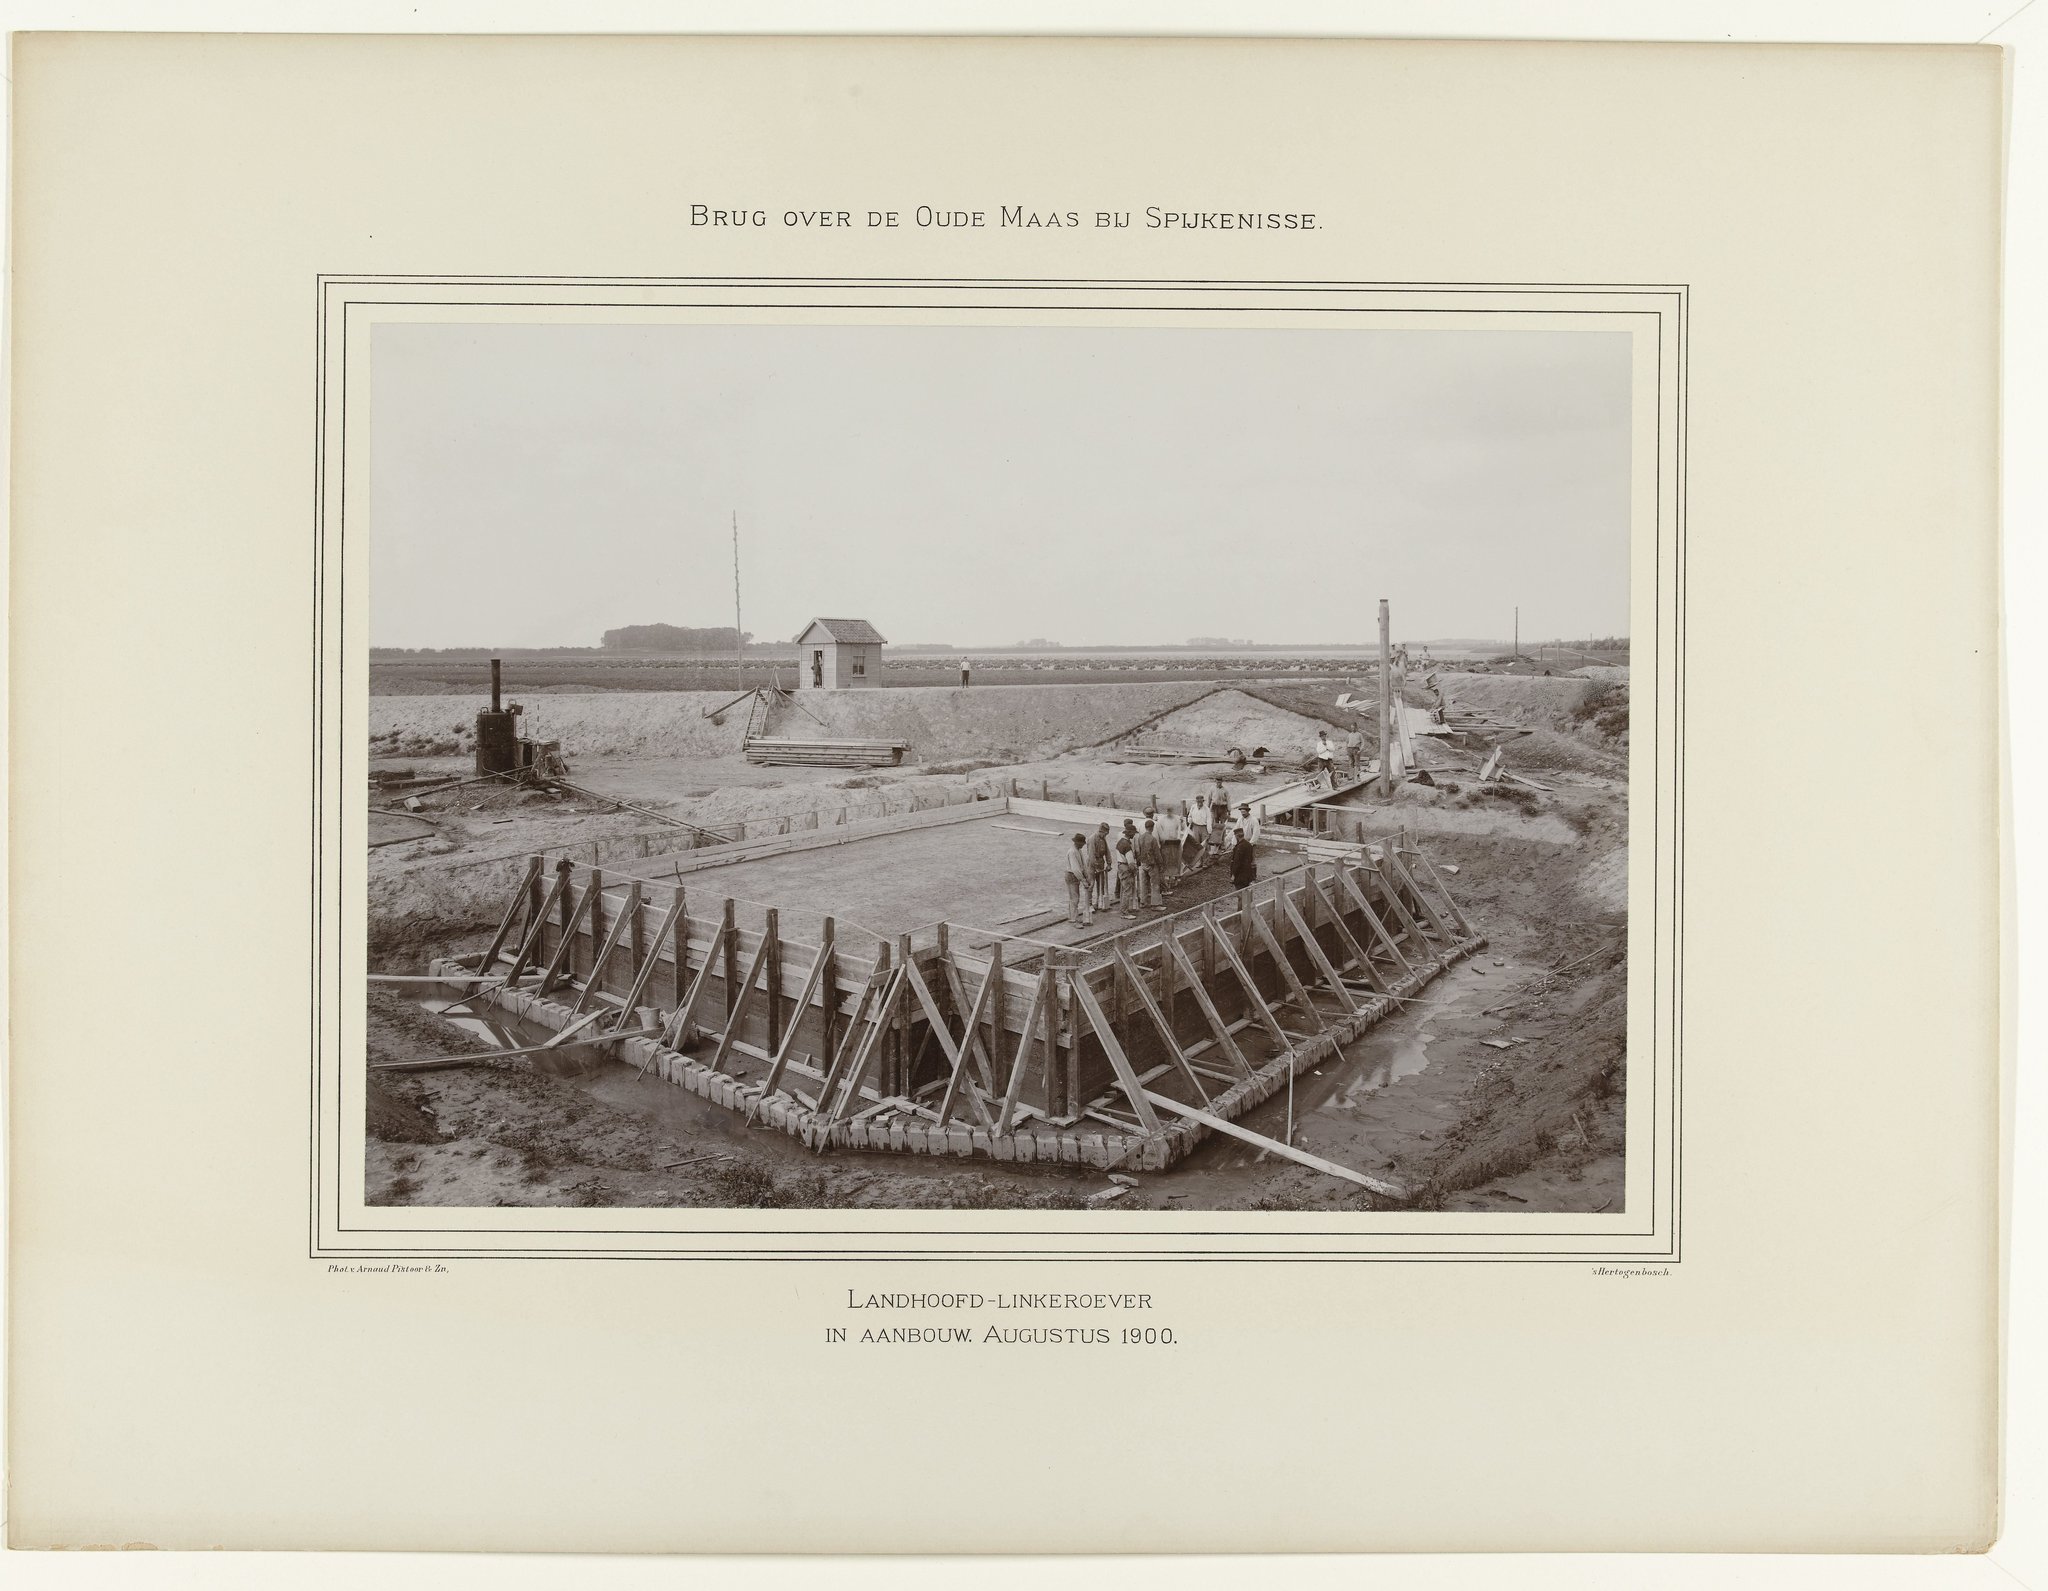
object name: photograph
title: Brug over de Oude Maas bij Spijkenisse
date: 1900-1908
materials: cardboard, photographic support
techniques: collodion silver print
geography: den bosch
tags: building-site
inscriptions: date